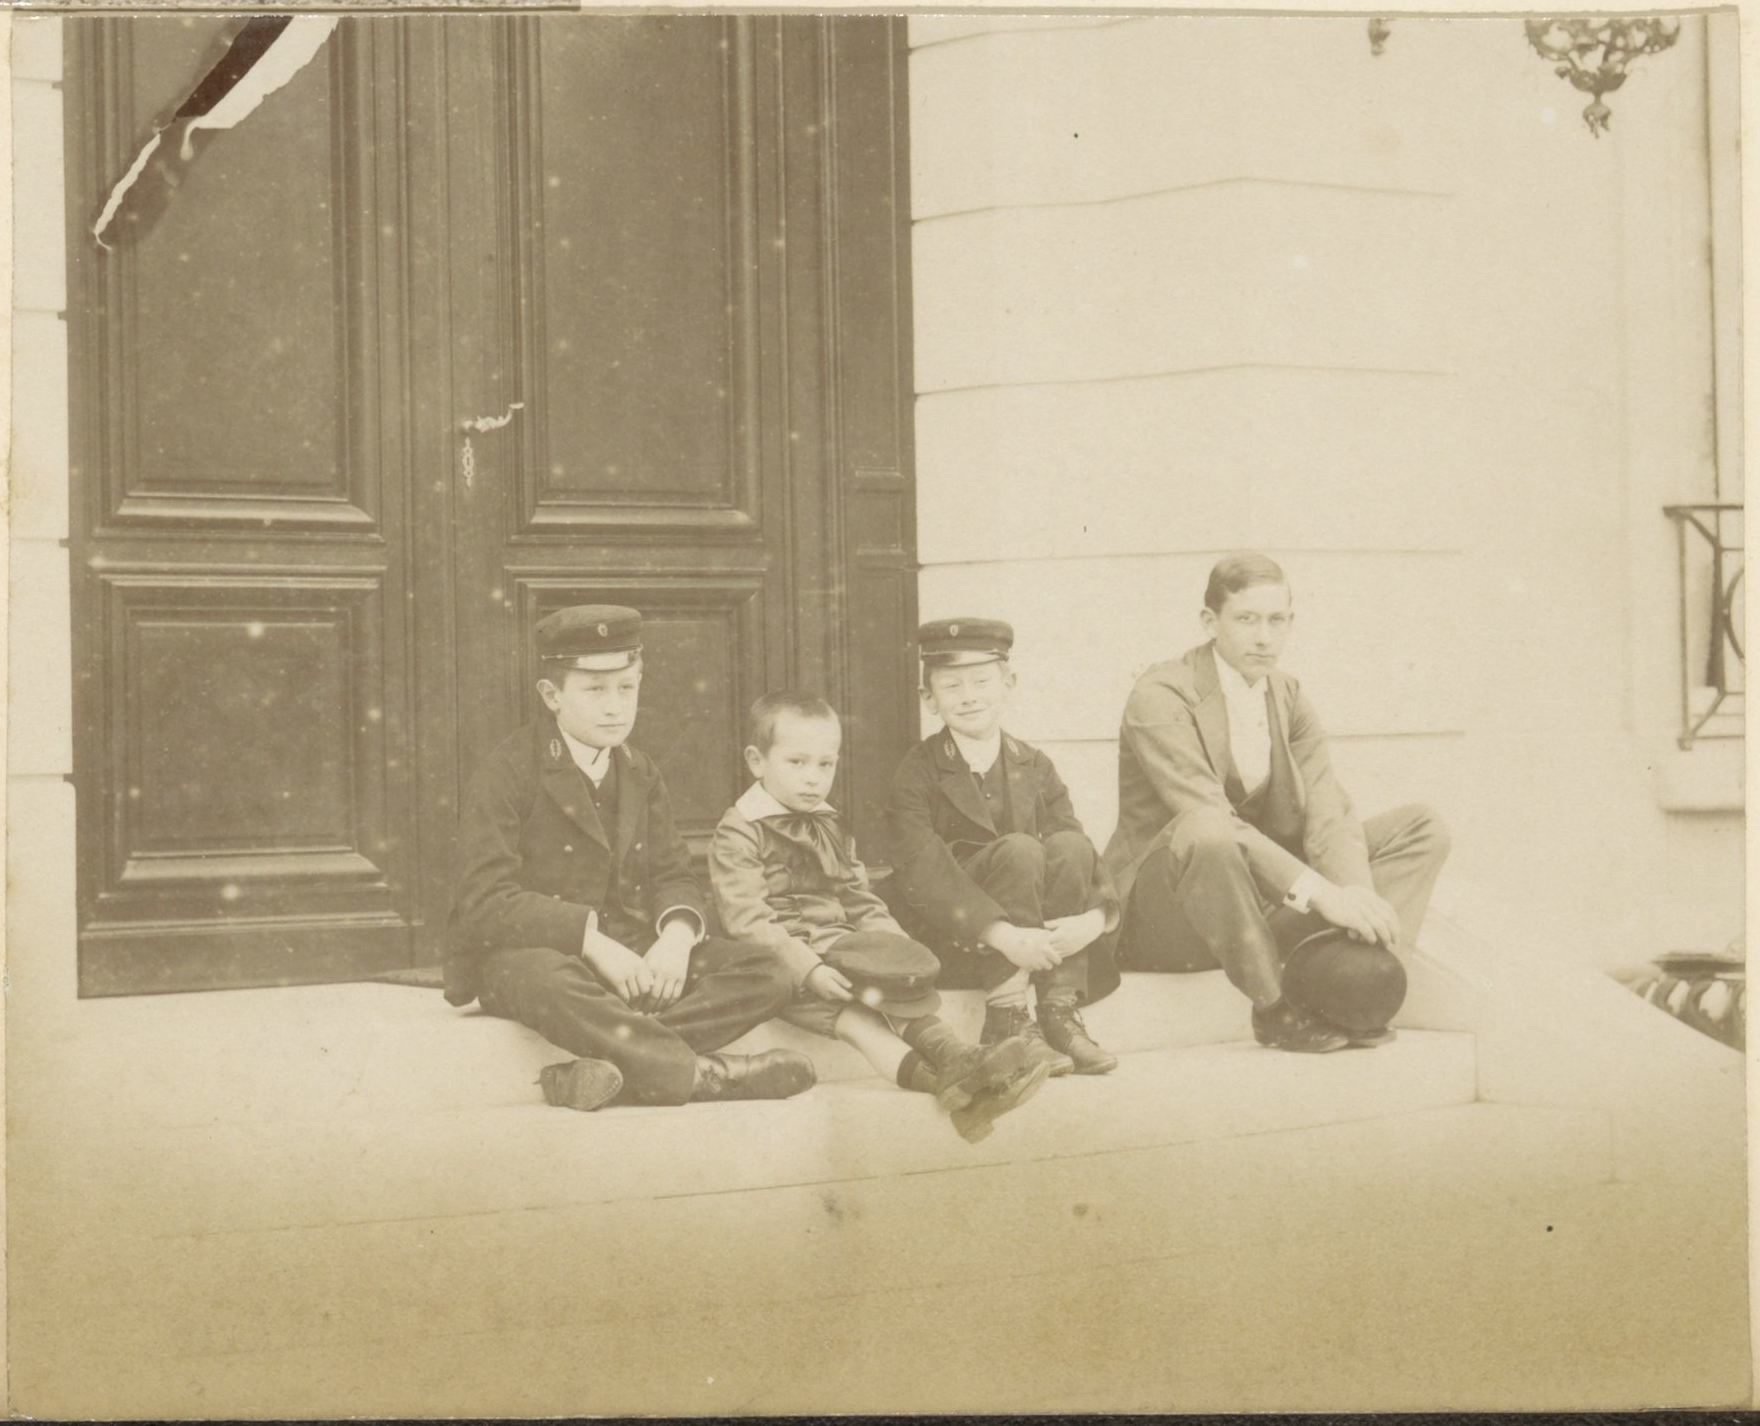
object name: photograph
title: Groepsportret van vier zittende Franse jongens voor een deur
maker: Anonymous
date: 1900-1910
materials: paper, photographic support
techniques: albumen print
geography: france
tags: child, france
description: Onderdeel van Fotoalbum van een Franse amateurfotograaf met opnames van een familie, distilleerderij Delizy & Doistau Fils, het leger en bezienswaardigheden in Frankrijk.